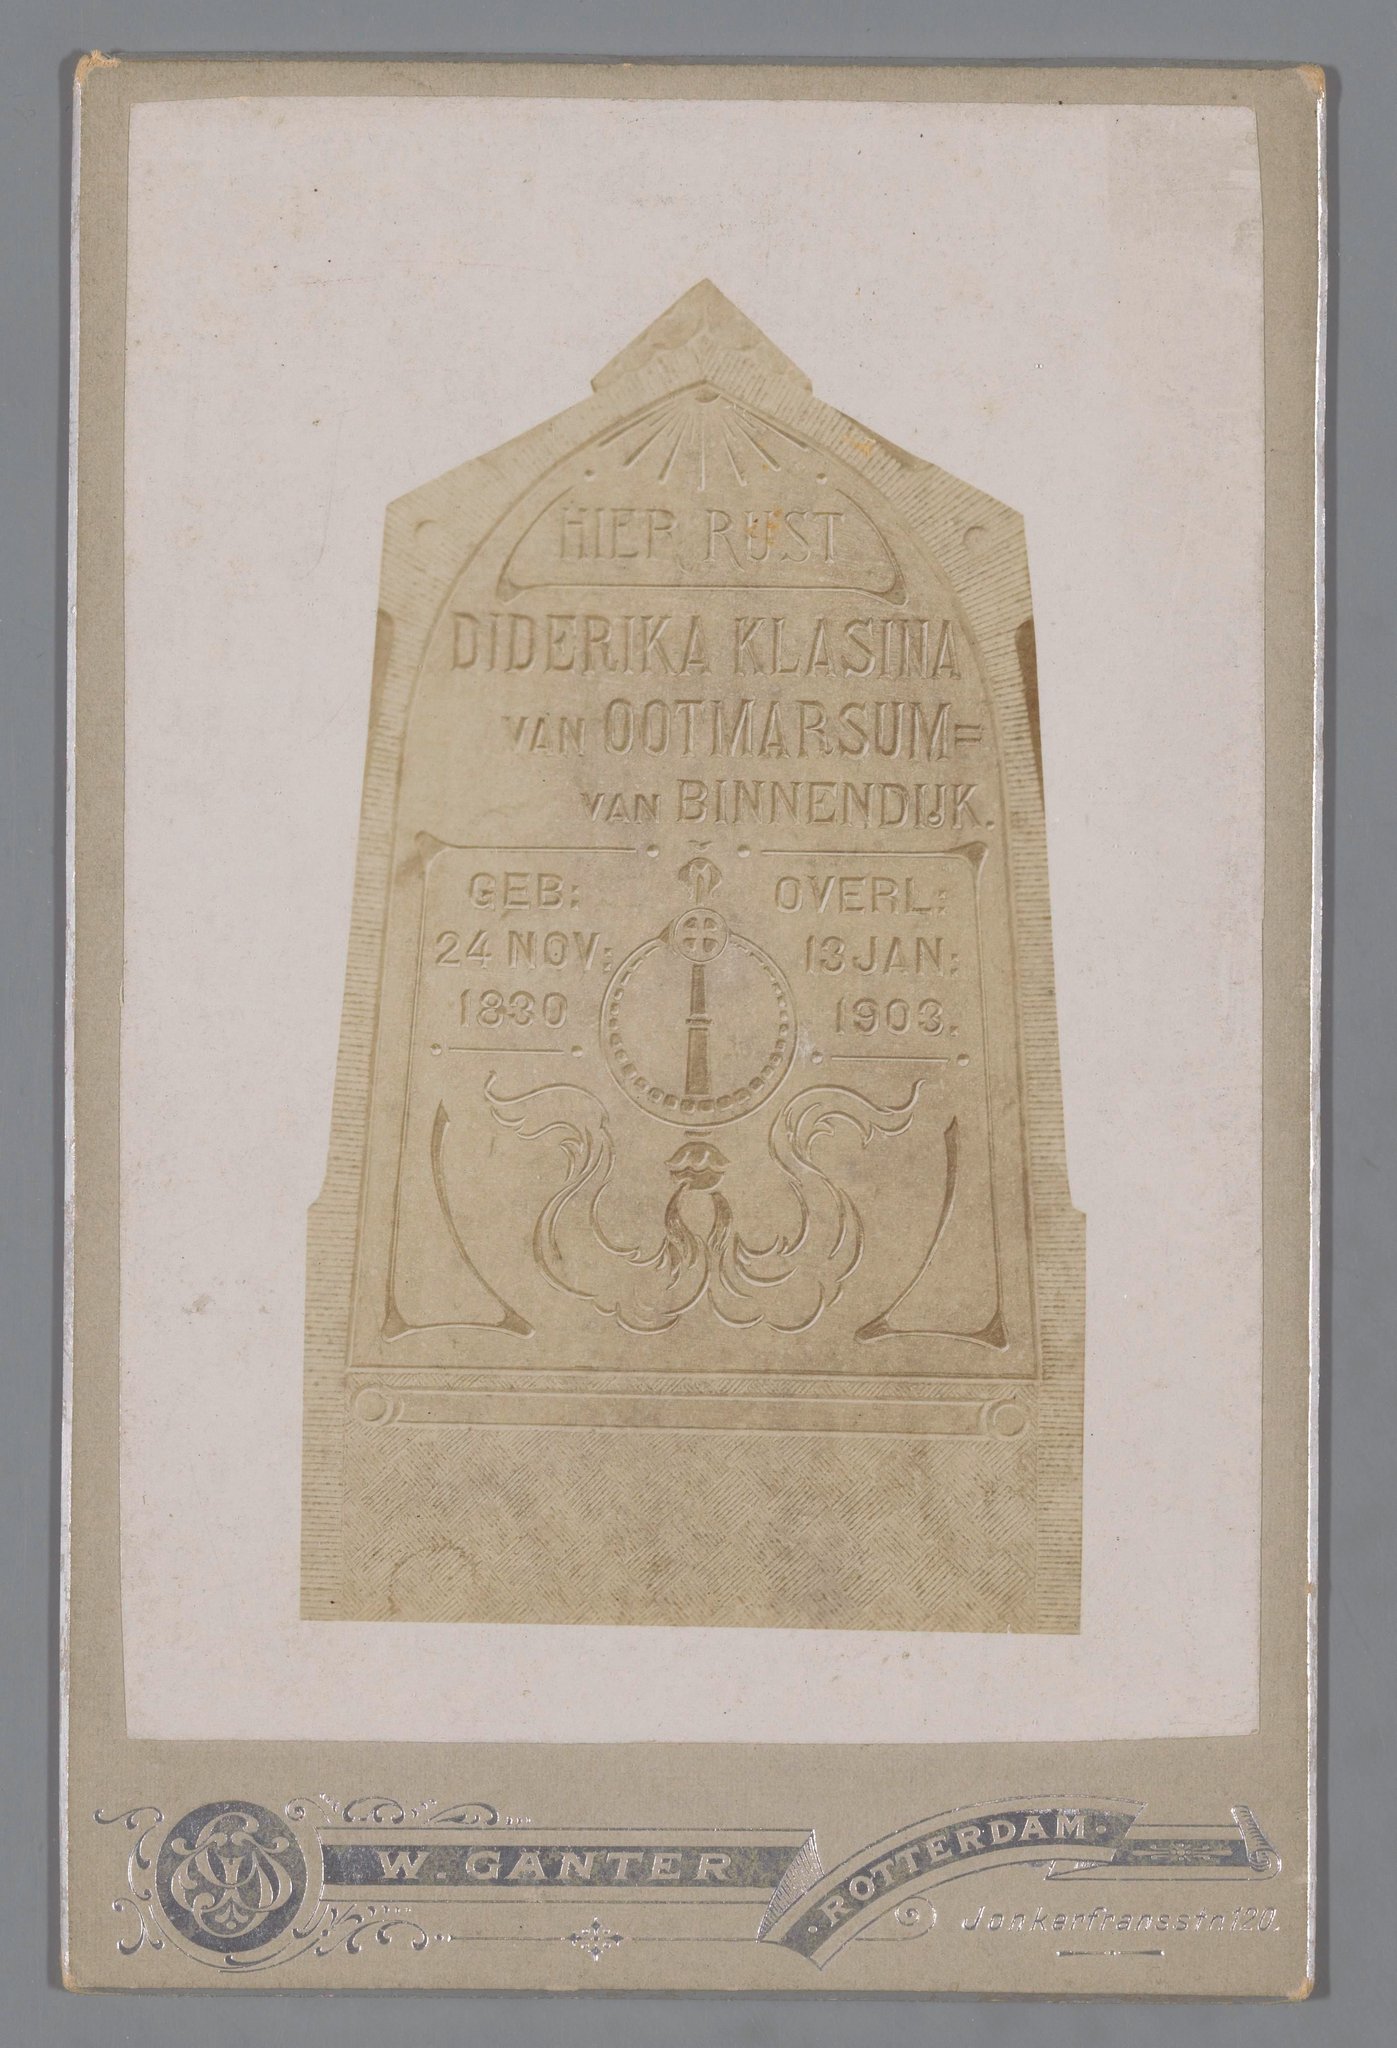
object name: cabinet photograph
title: Grafsteen van Dikerika Klasina van Ootmarsum-Van Binnendijk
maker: willem ganter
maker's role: fotograaf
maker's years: 1849-1908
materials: cardboard, photographic support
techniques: collodion silver print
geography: rotterdam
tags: grave, tomb and other grave-forms and grave-markers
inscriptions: name: ‘Photographie Artistique Wm Ganter Hofleverancier Jonker Fransstraat 120. Rotterdam’